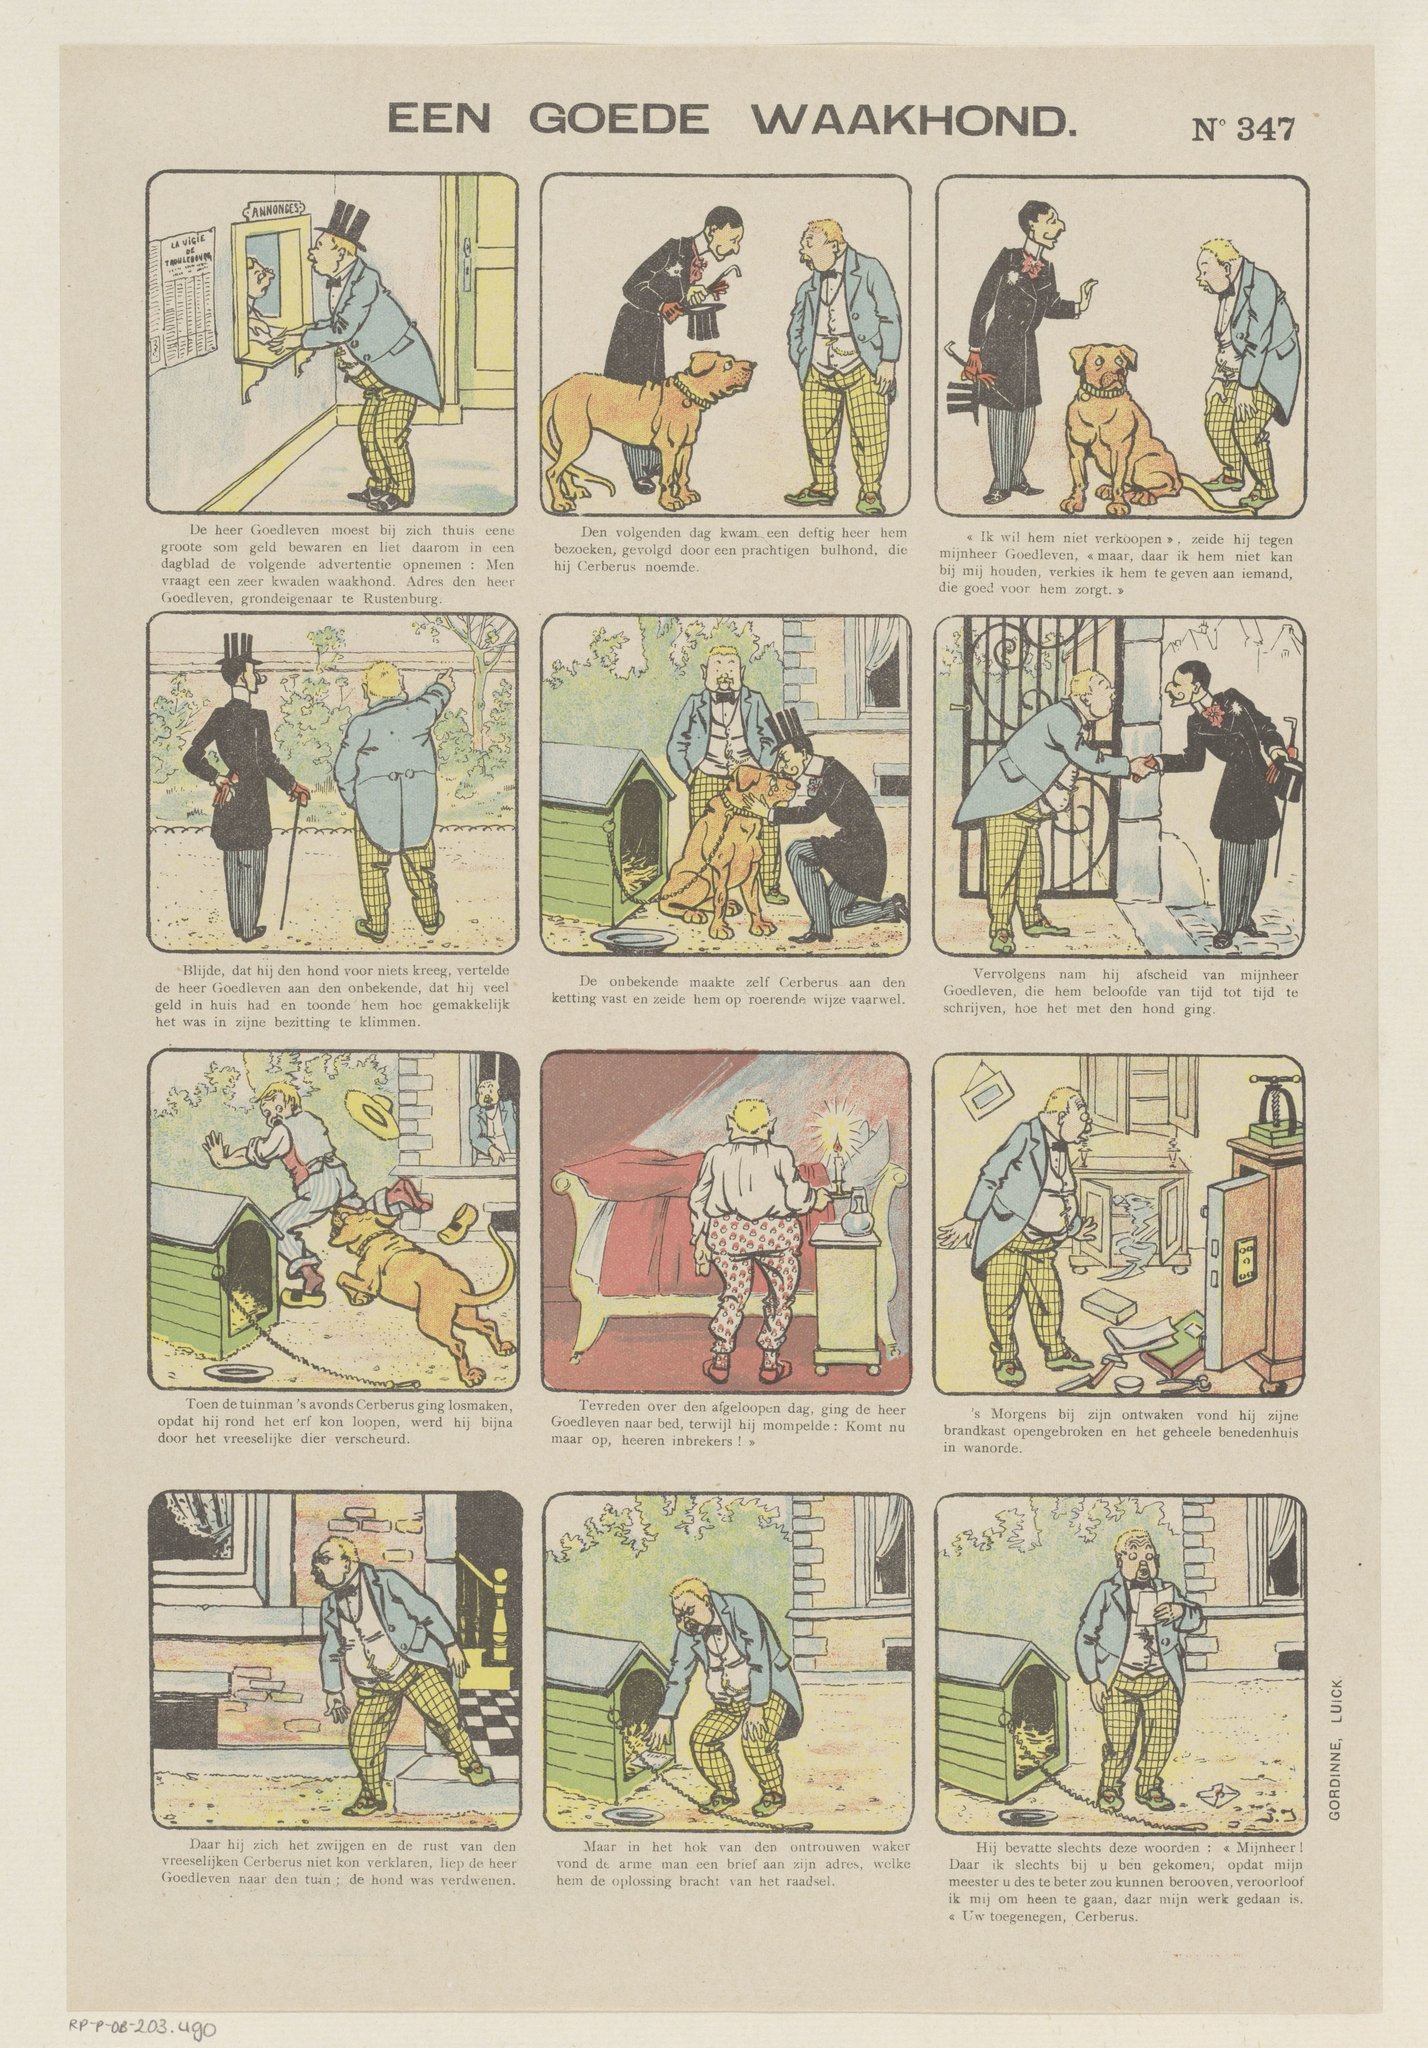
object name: popular print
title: Een goede waakhond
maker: monogrammist g.j.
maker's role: print maker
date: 1894-1959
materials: paper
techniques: lithograph, letterpress printing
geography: liège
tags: burglar, housebreaker, watch-dog, dog watching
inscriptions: collector's mark: Lugt 2760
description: Blad met 12 voorstellingen over de heer Goedleven die een waakhond neemt. Het voormalige baasje van de waakhond berooft de heer Goedleven en neemt zijn hond weer mee. Onder elke afbeelding een onderschrift. Genummerd rechtsboven: No 347.